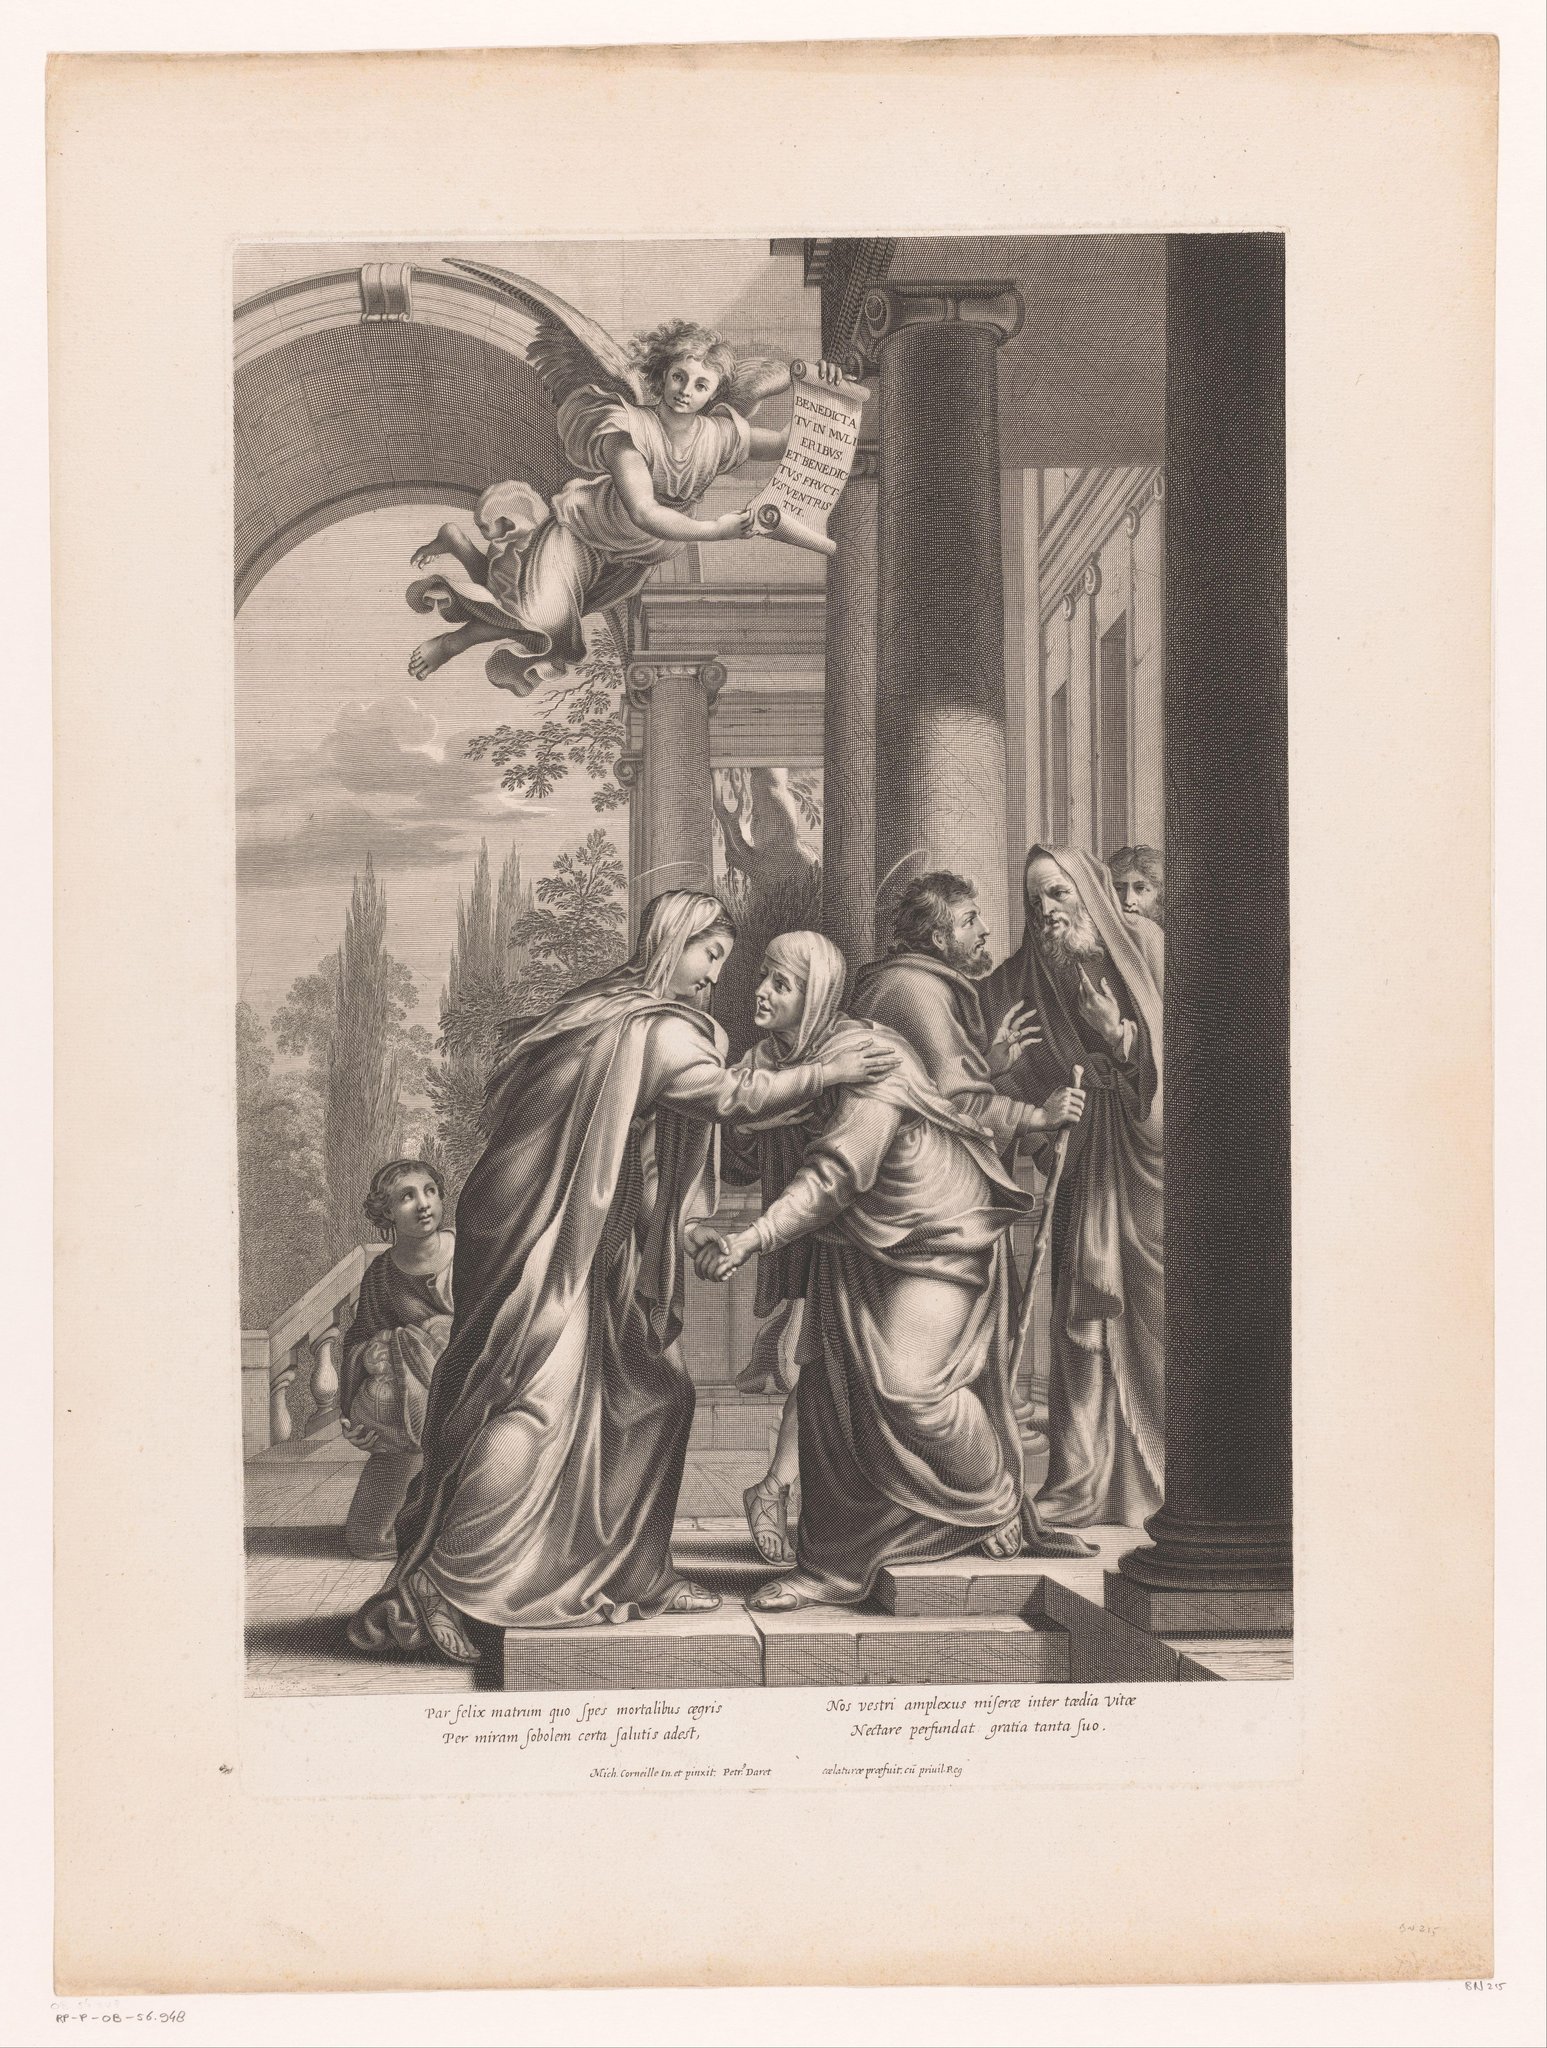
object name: print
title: Visitatie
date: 1614-1678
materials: paper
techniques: engraving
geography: france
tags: visitation (possibly joseph and/or zacharias present) (luke 1:39-56)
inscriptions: collector's mark: Lugt 240